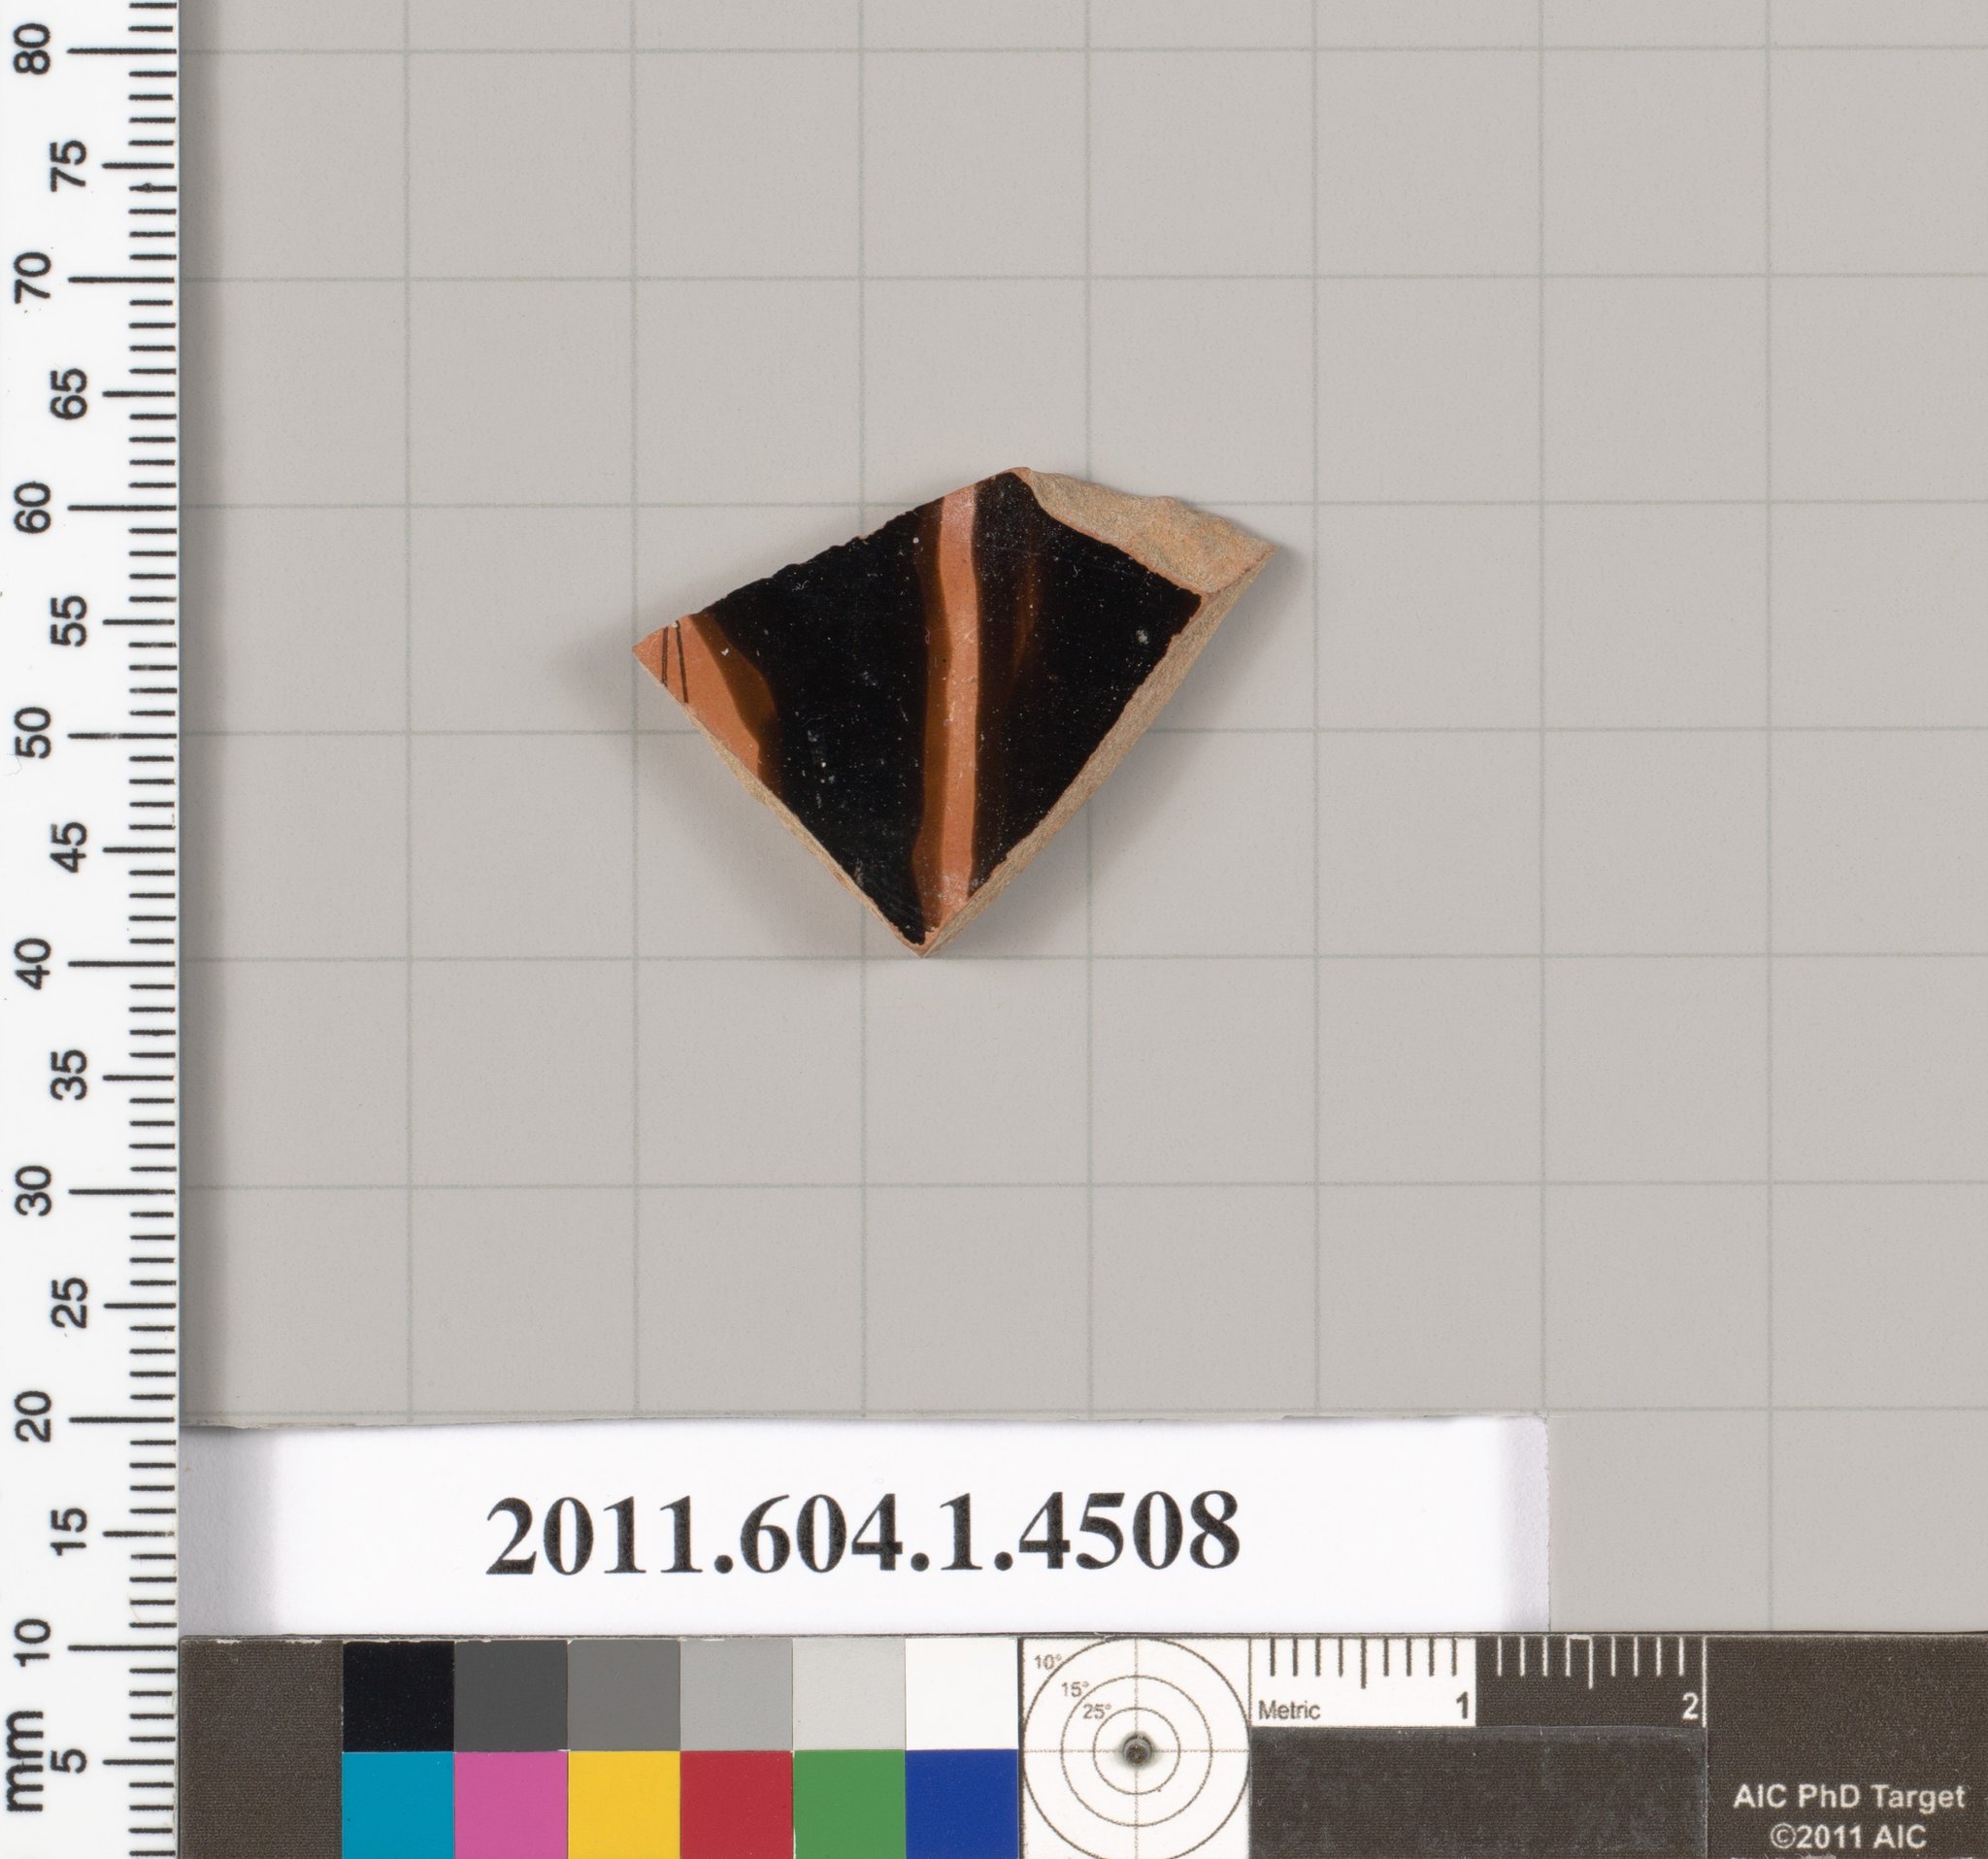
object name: kylix fragment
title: Terracotta fragment of a kylix (drinking cup)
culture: greek, attic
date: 475-451 BCE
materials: terracotta